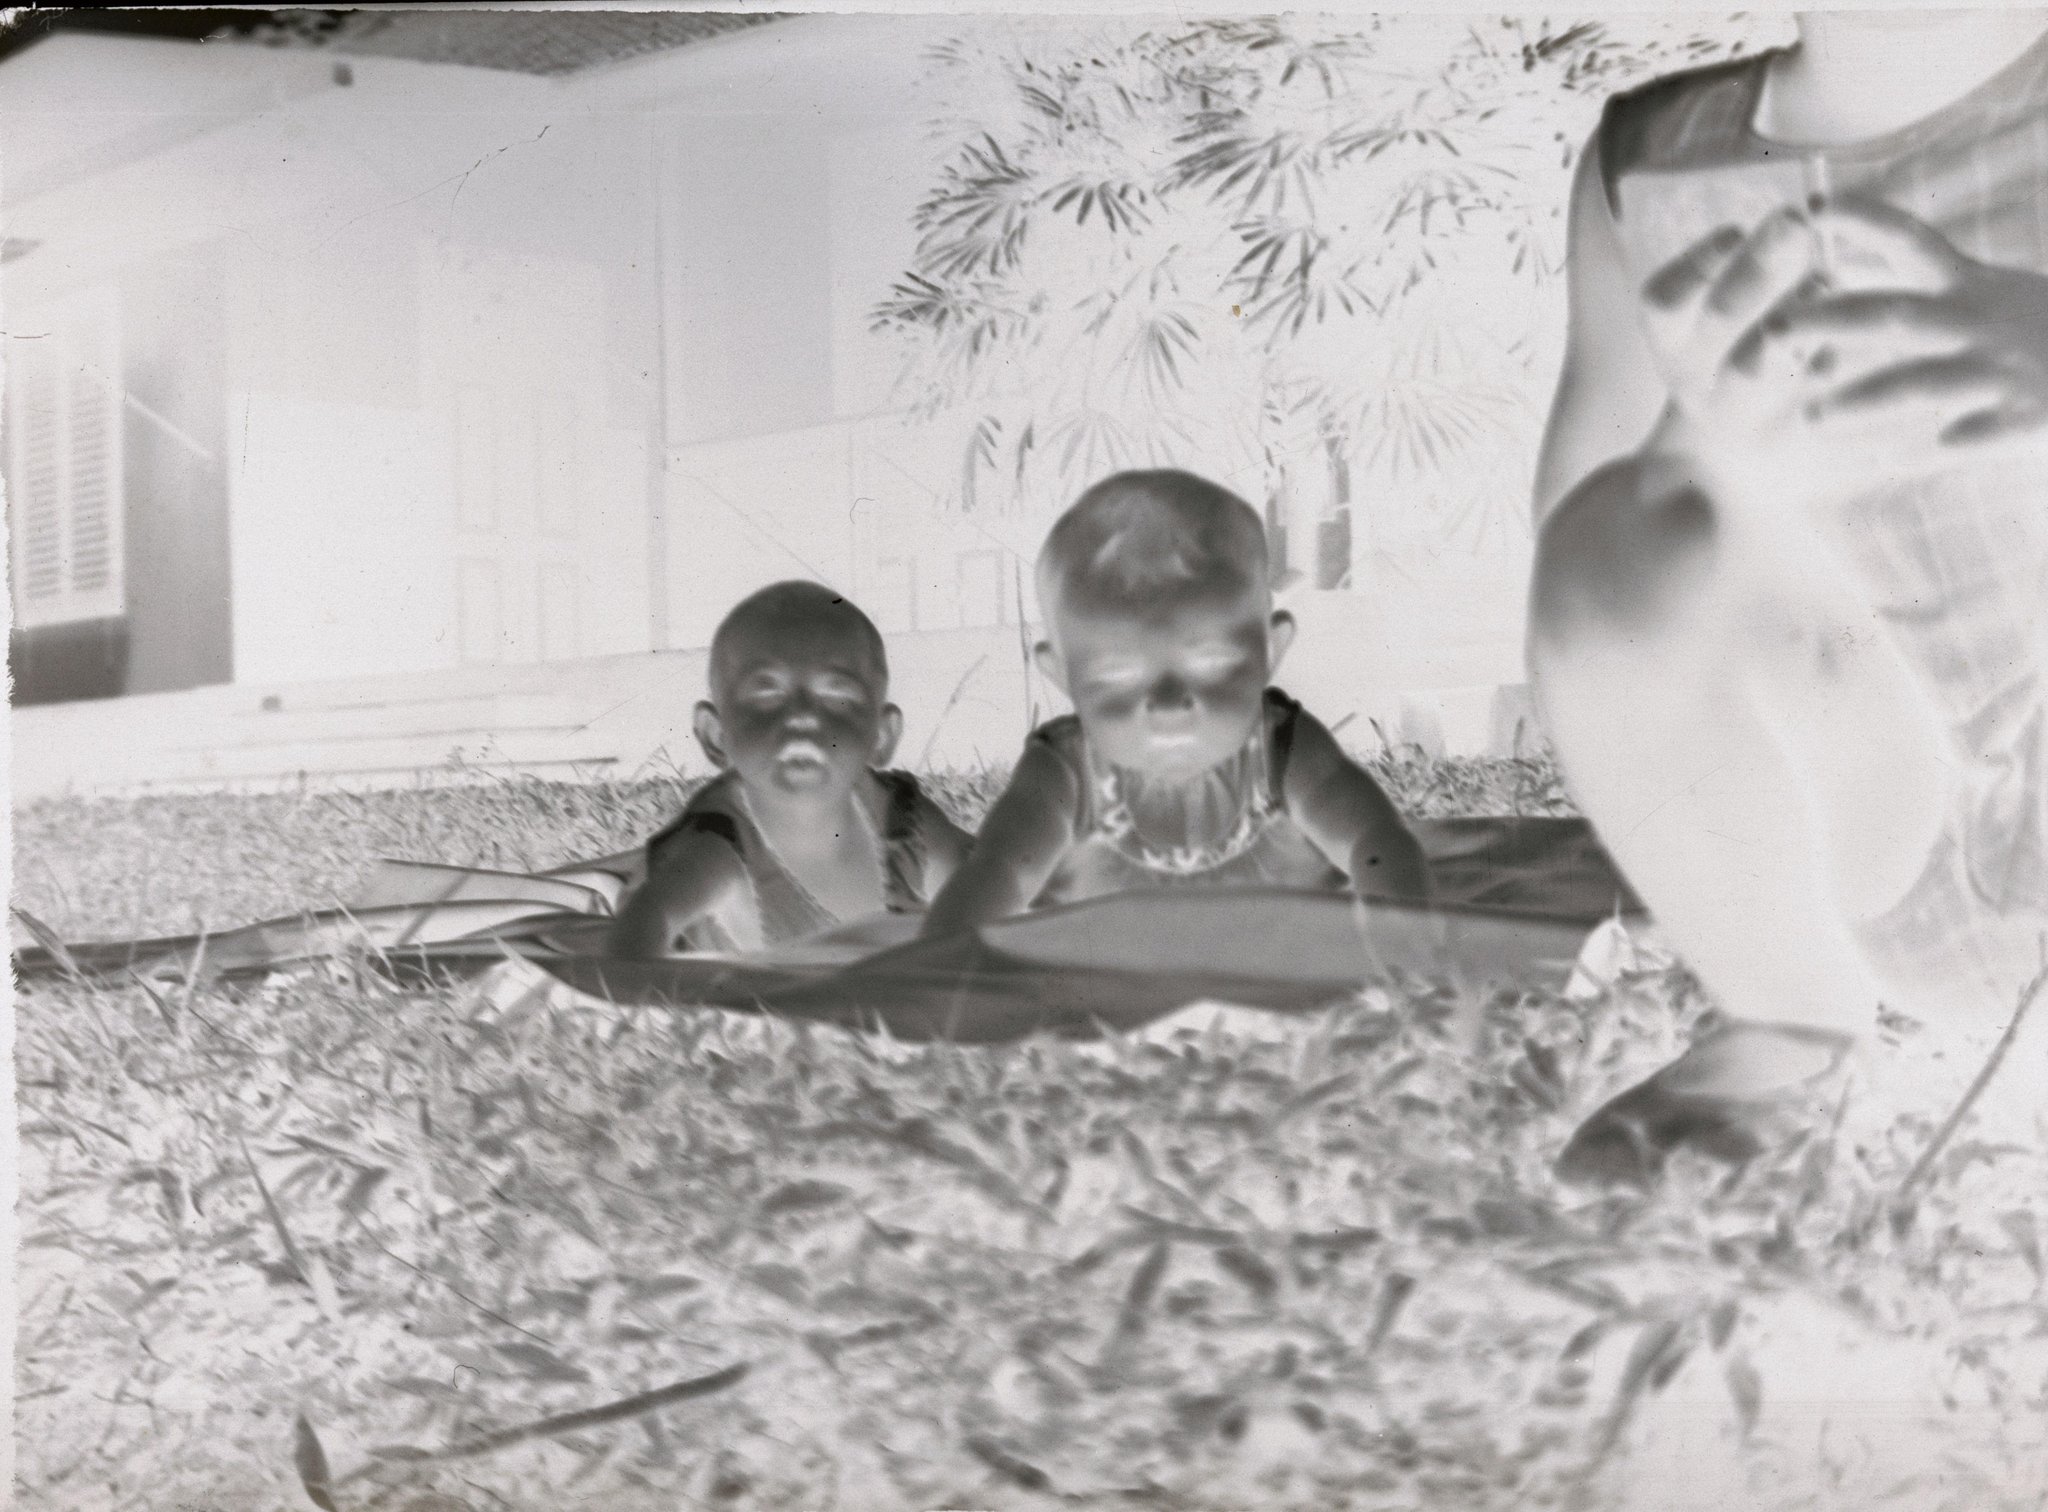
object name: negative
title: Twee kinderen aangeduid als 'Fritsje en zijn vriendinnetje' op een gazon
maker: Anonymous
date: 1928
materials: film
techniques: gelatin silver negative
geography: dutch east indies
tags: child, dutch east indies, the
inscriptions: number: ‘2’, number: ‘20’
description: Onderdeel van Kodak negatievenalbum met 35 foto's van een familie in Nederlands-Indië.